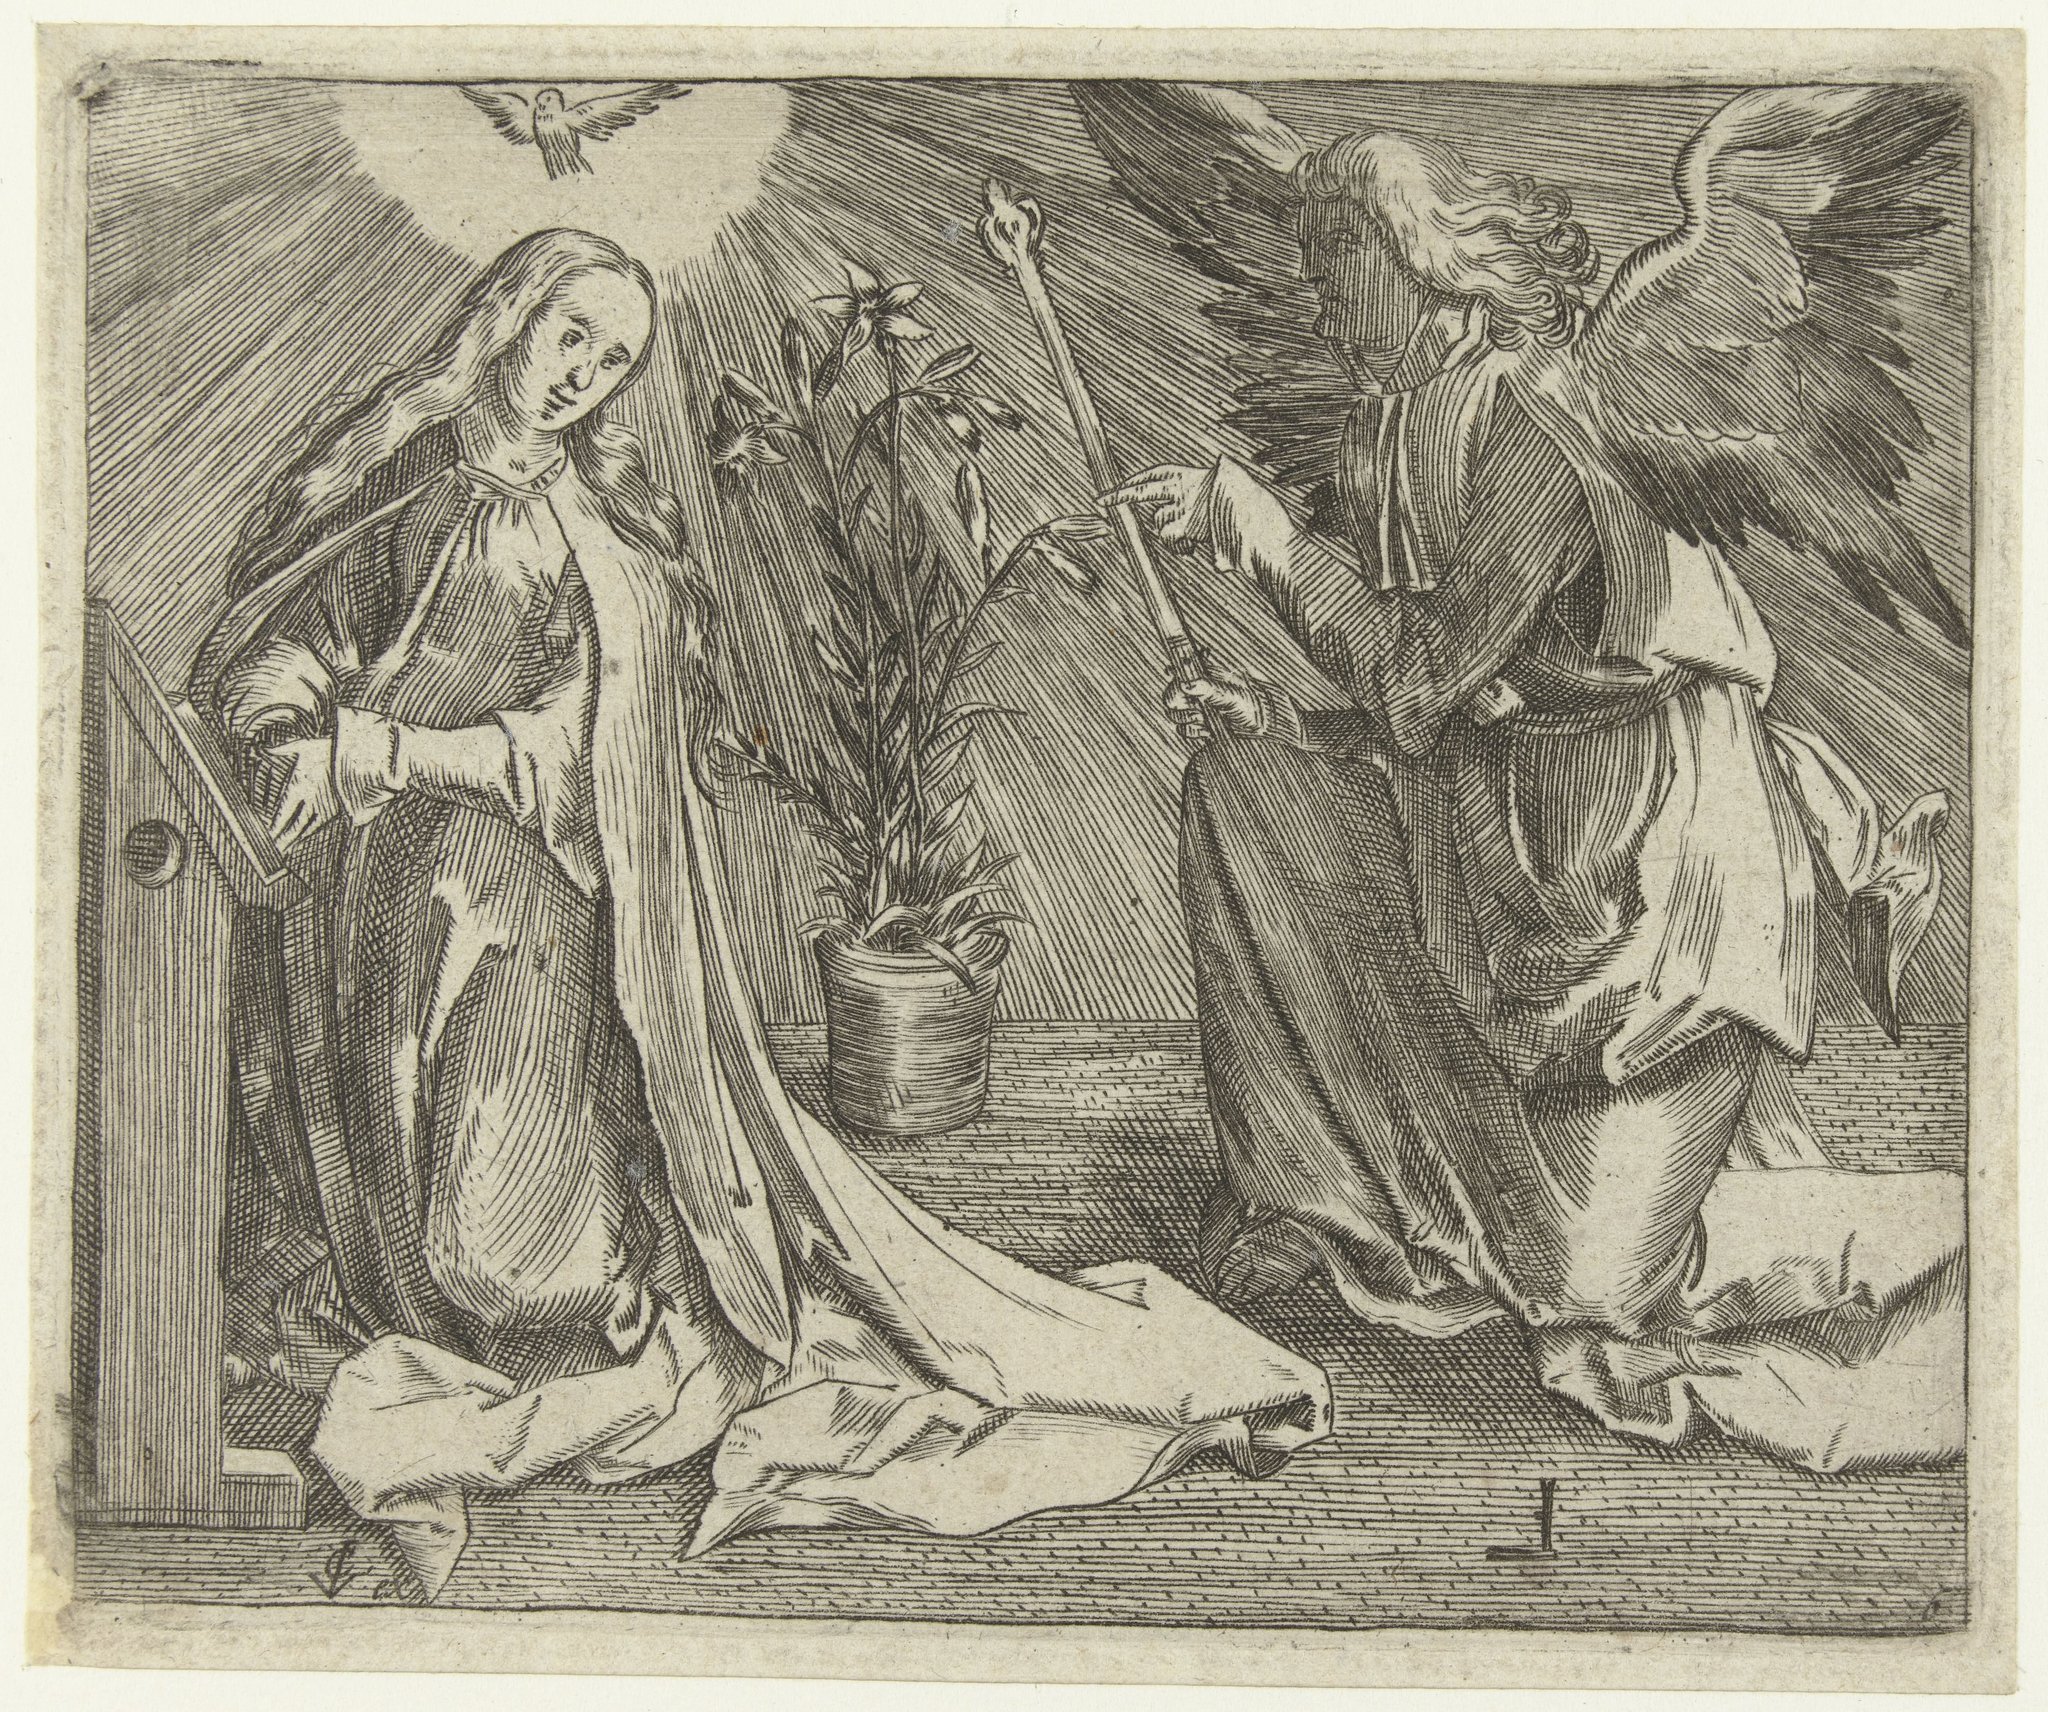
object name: print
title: Annunciatie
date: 1504-1583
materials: paper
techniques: engraving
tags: the annunciation: mary kneeling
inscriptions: collector's mark: Lugt 240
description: Aartsengel Gabriel geknield bij Maria. Boven haar hoofd de Heilige Geest. Kopie in spiegelbeeld.